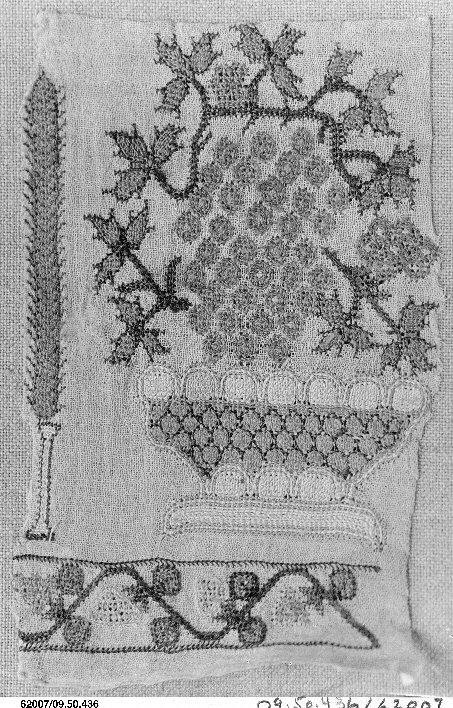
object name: fragment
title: Textile Fragment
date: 1701-1900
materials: linen, metal thread, silk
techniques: embroidery, weave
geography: syria